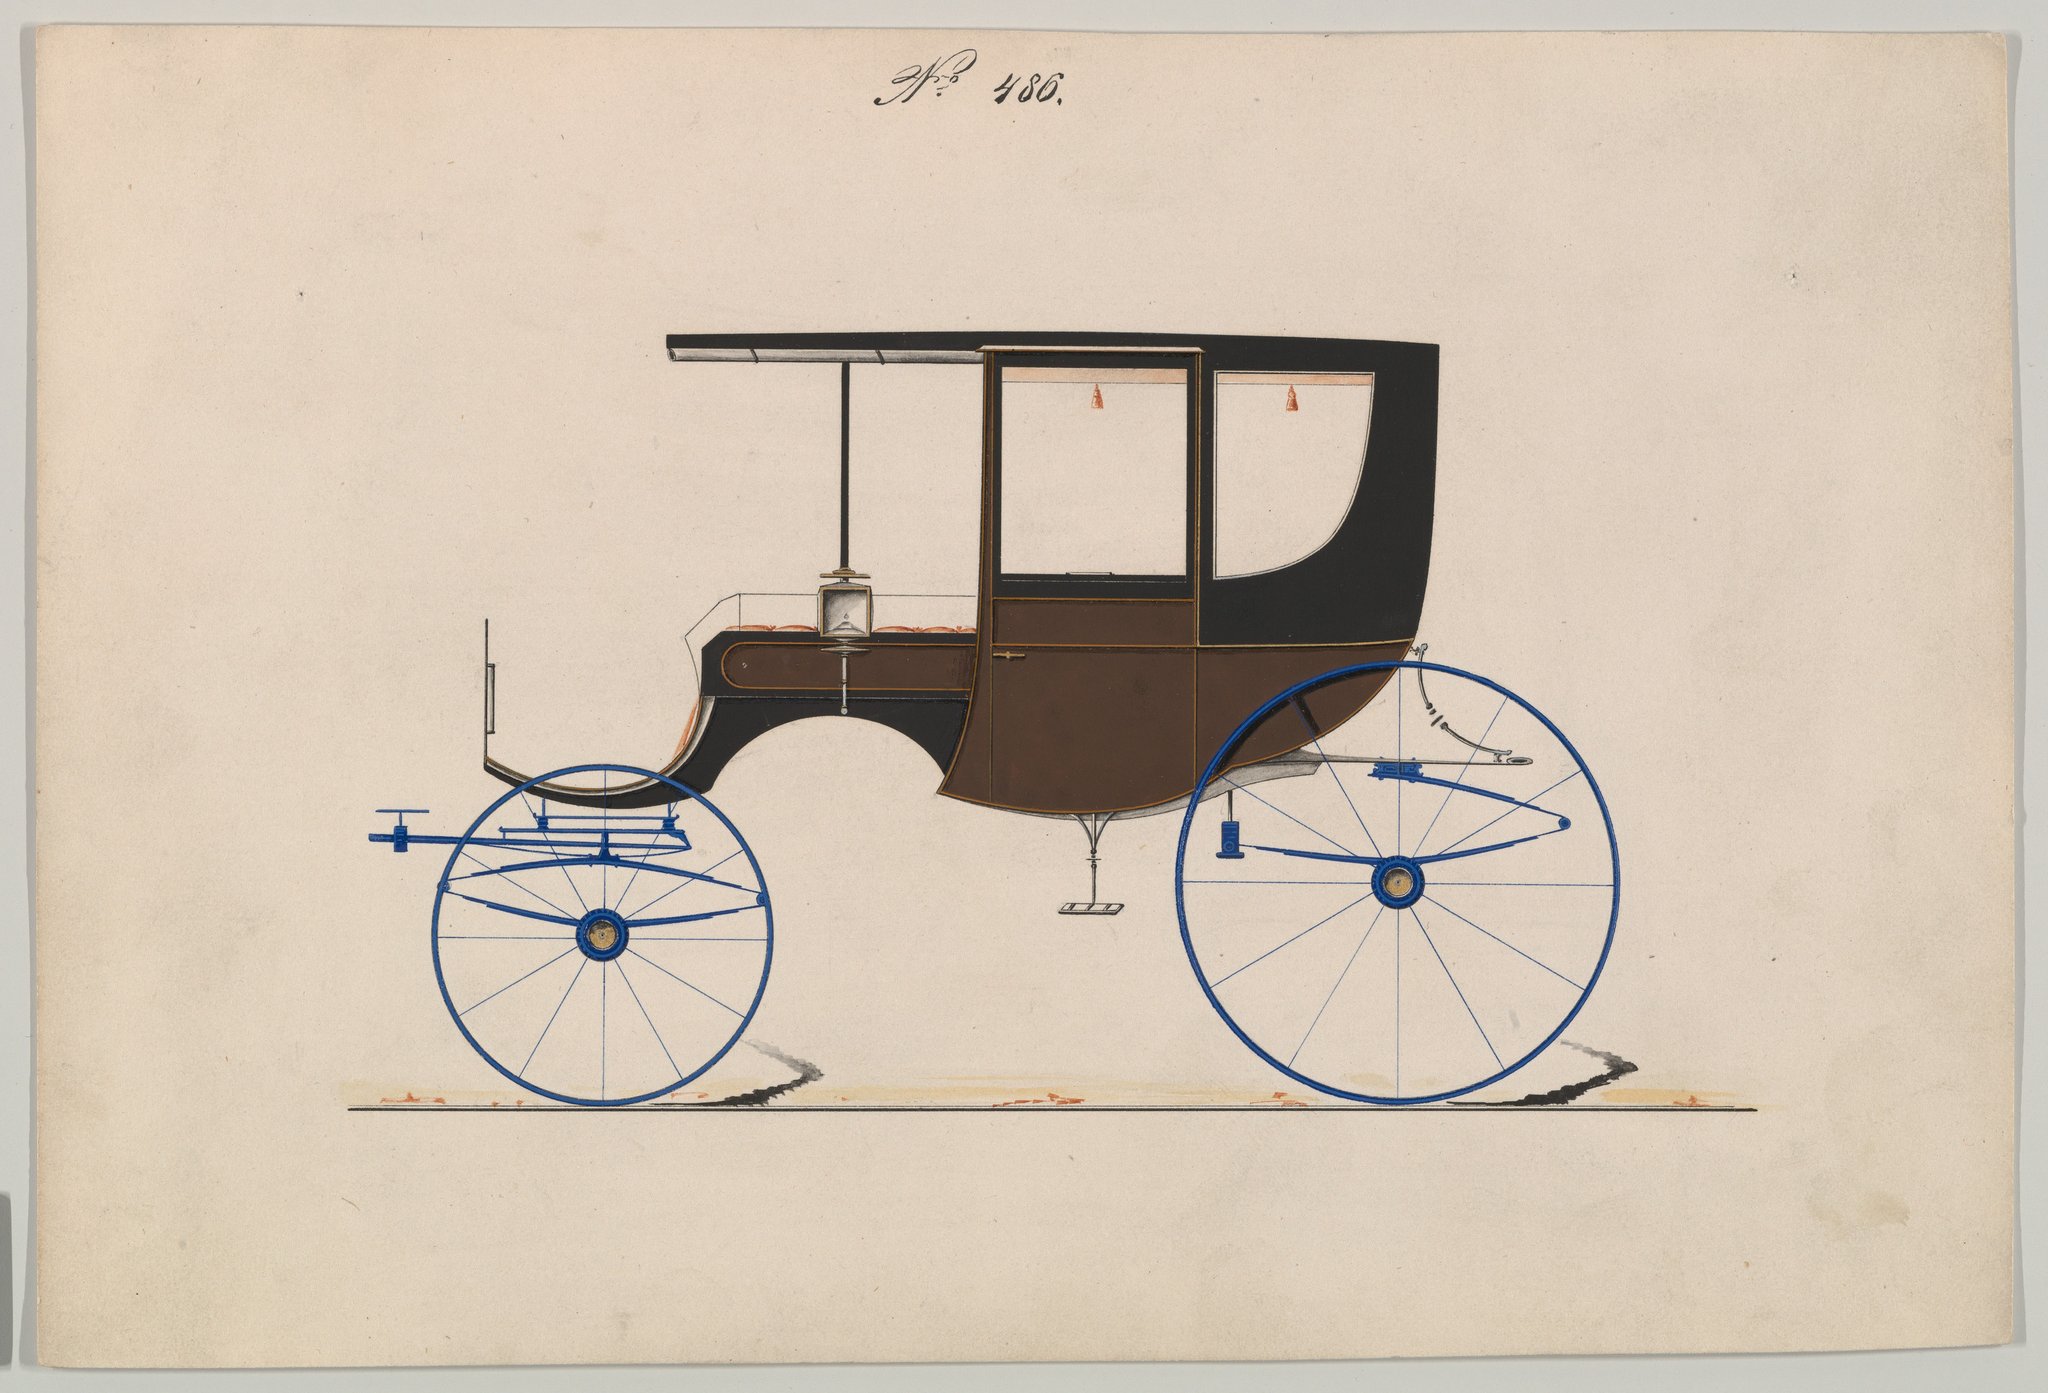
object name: drawing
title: Rockaway #486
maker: brewster & co.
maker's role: manufacturer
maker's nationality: american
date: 1860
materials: gouache, gum arabic, ink, watercolor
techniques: pen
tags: carriages